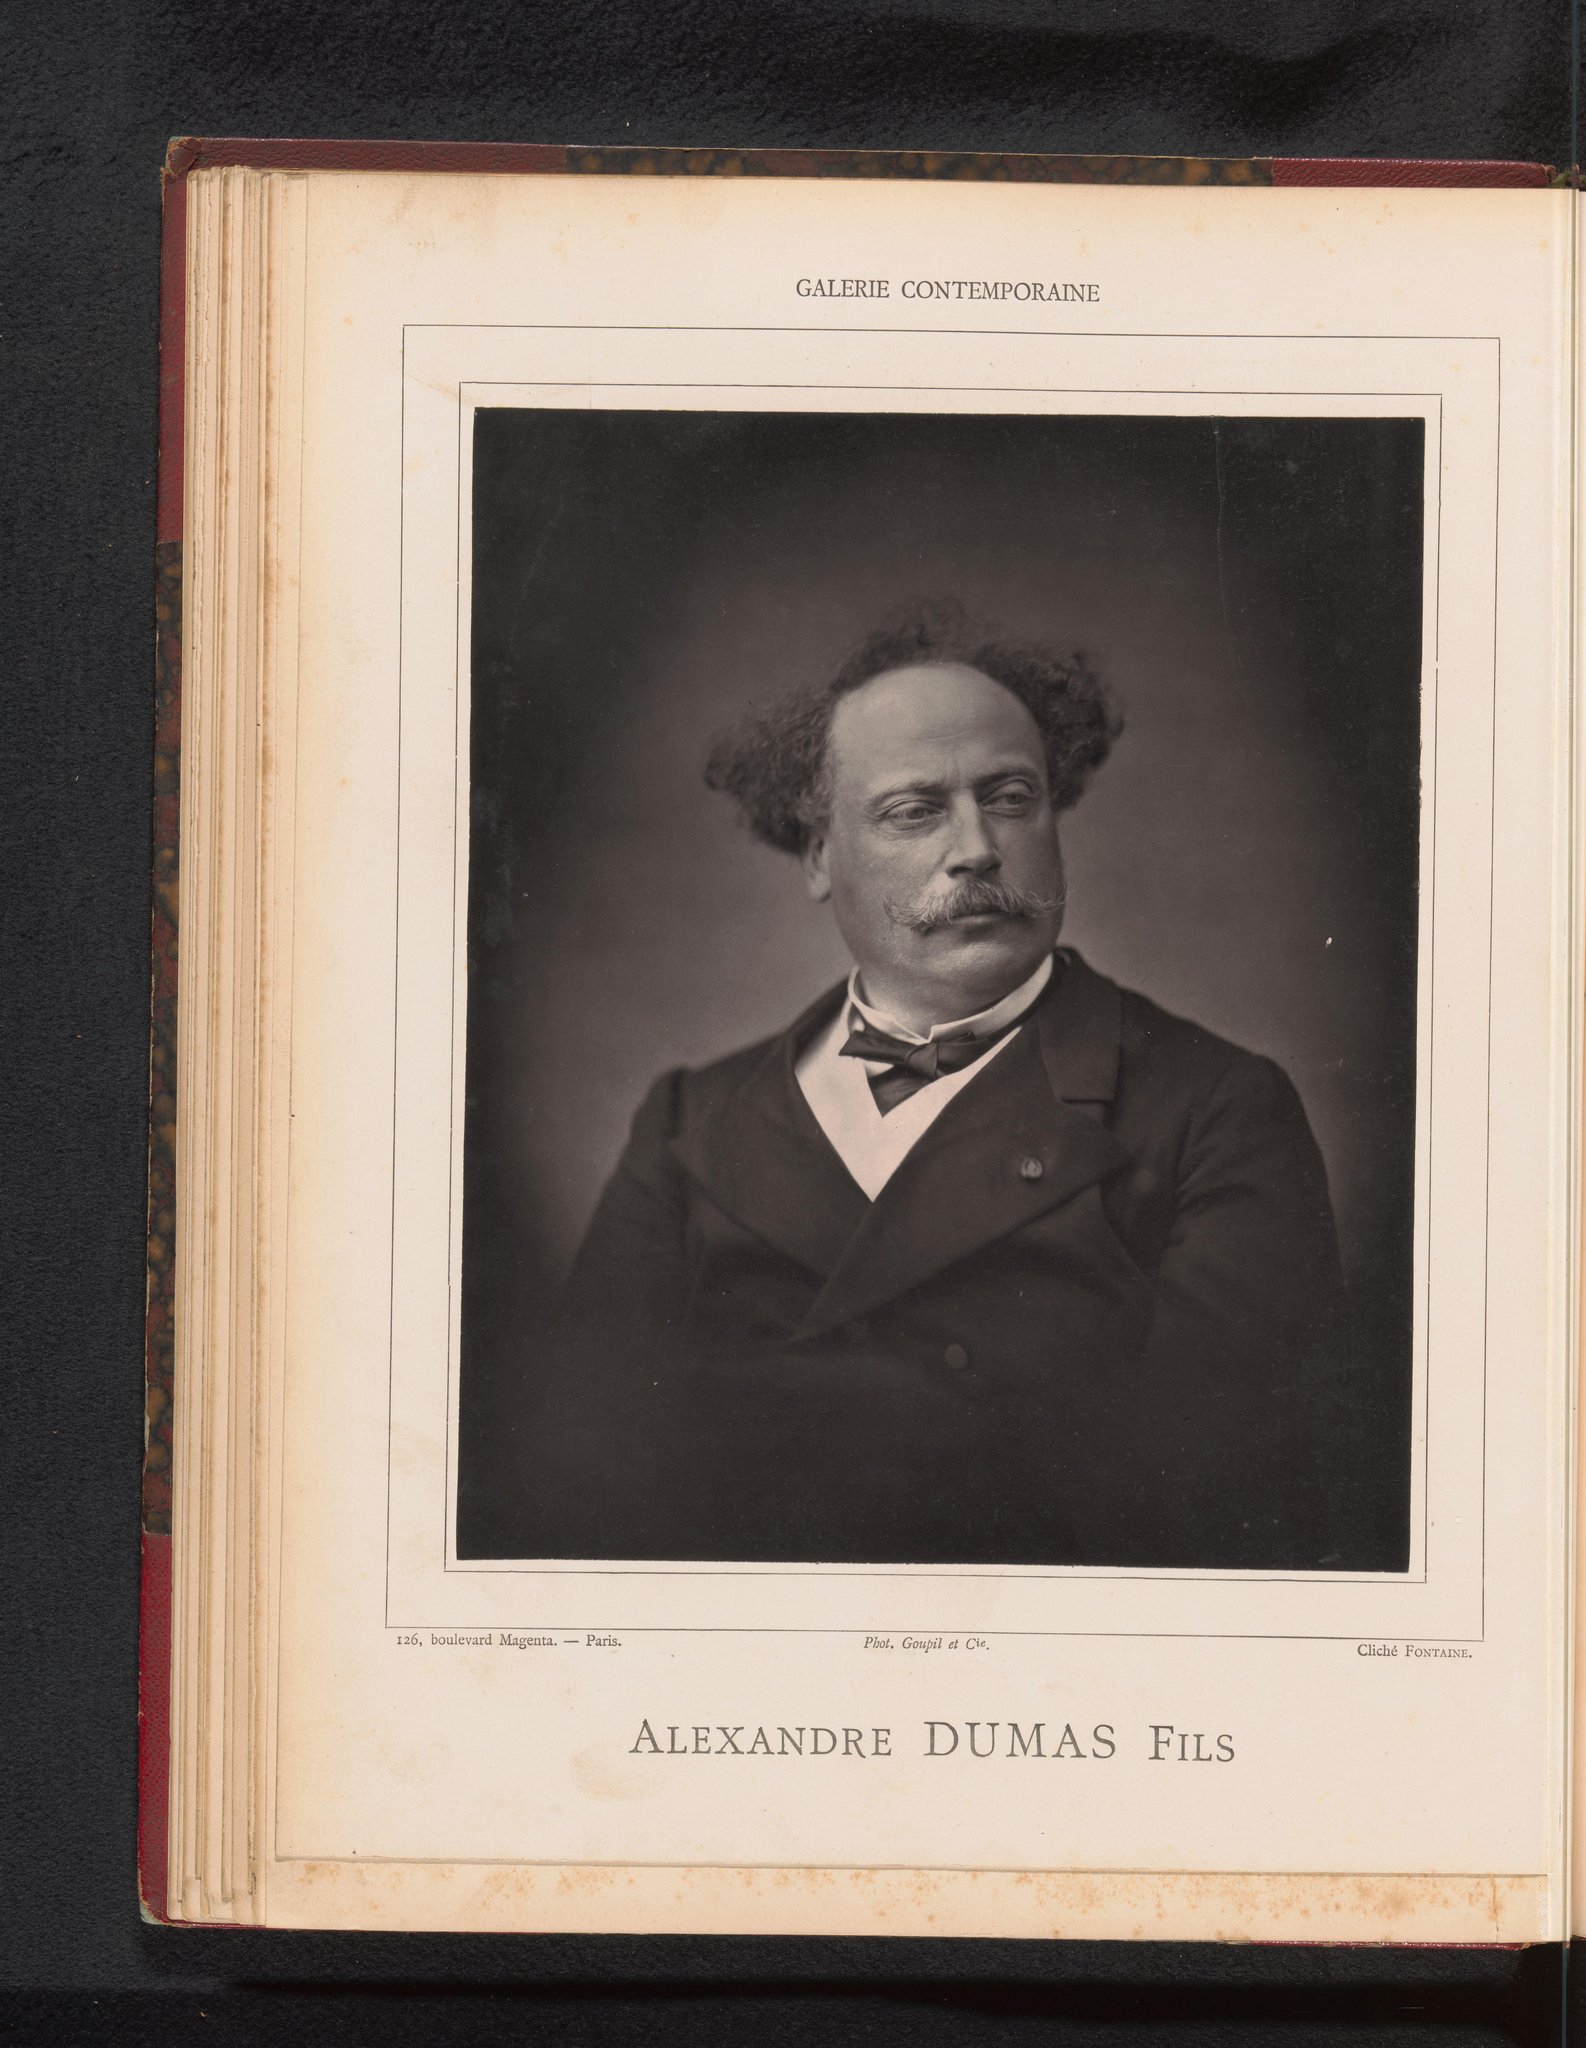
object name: photomechanical print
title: Portret van Alexanre Dumas Fils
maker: fontaine (fotograaf)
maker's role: clichémaker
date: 1871-1876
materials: paper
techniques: woodburytype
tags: paris, adult man, historical persons